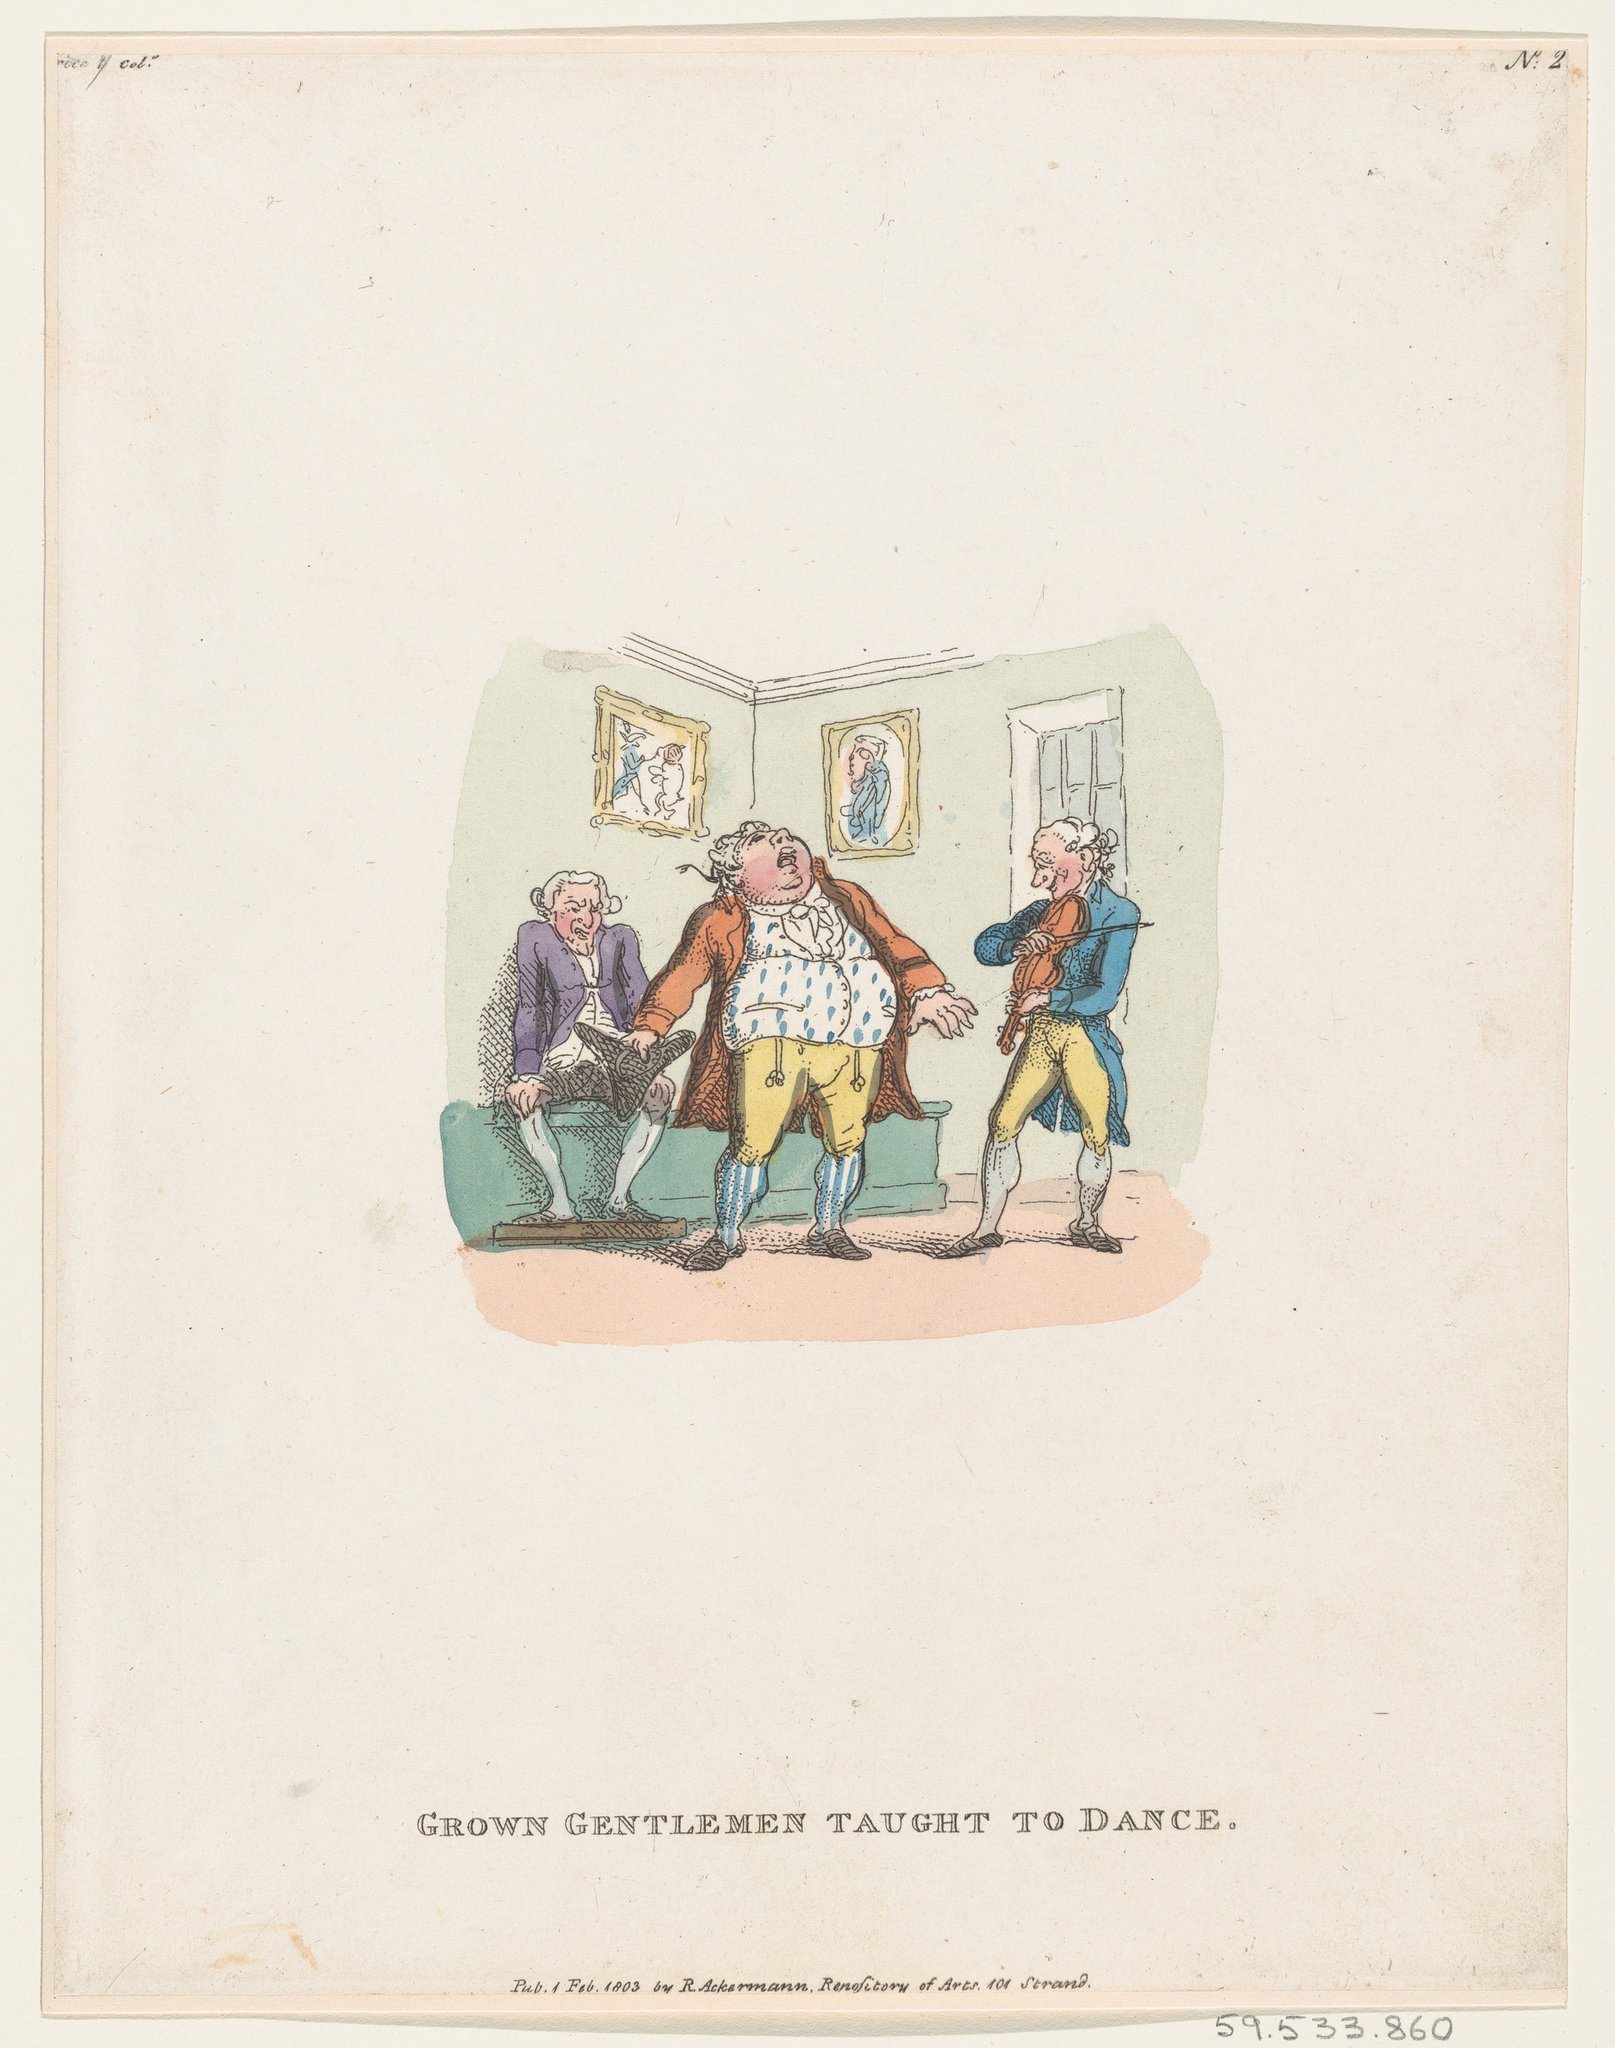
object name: print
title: Grown Gentlemen Taught to Dance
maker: henry william bunbury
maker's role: artist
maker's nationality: british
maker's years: 1750-1811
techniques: etching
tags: satire,men,musicians